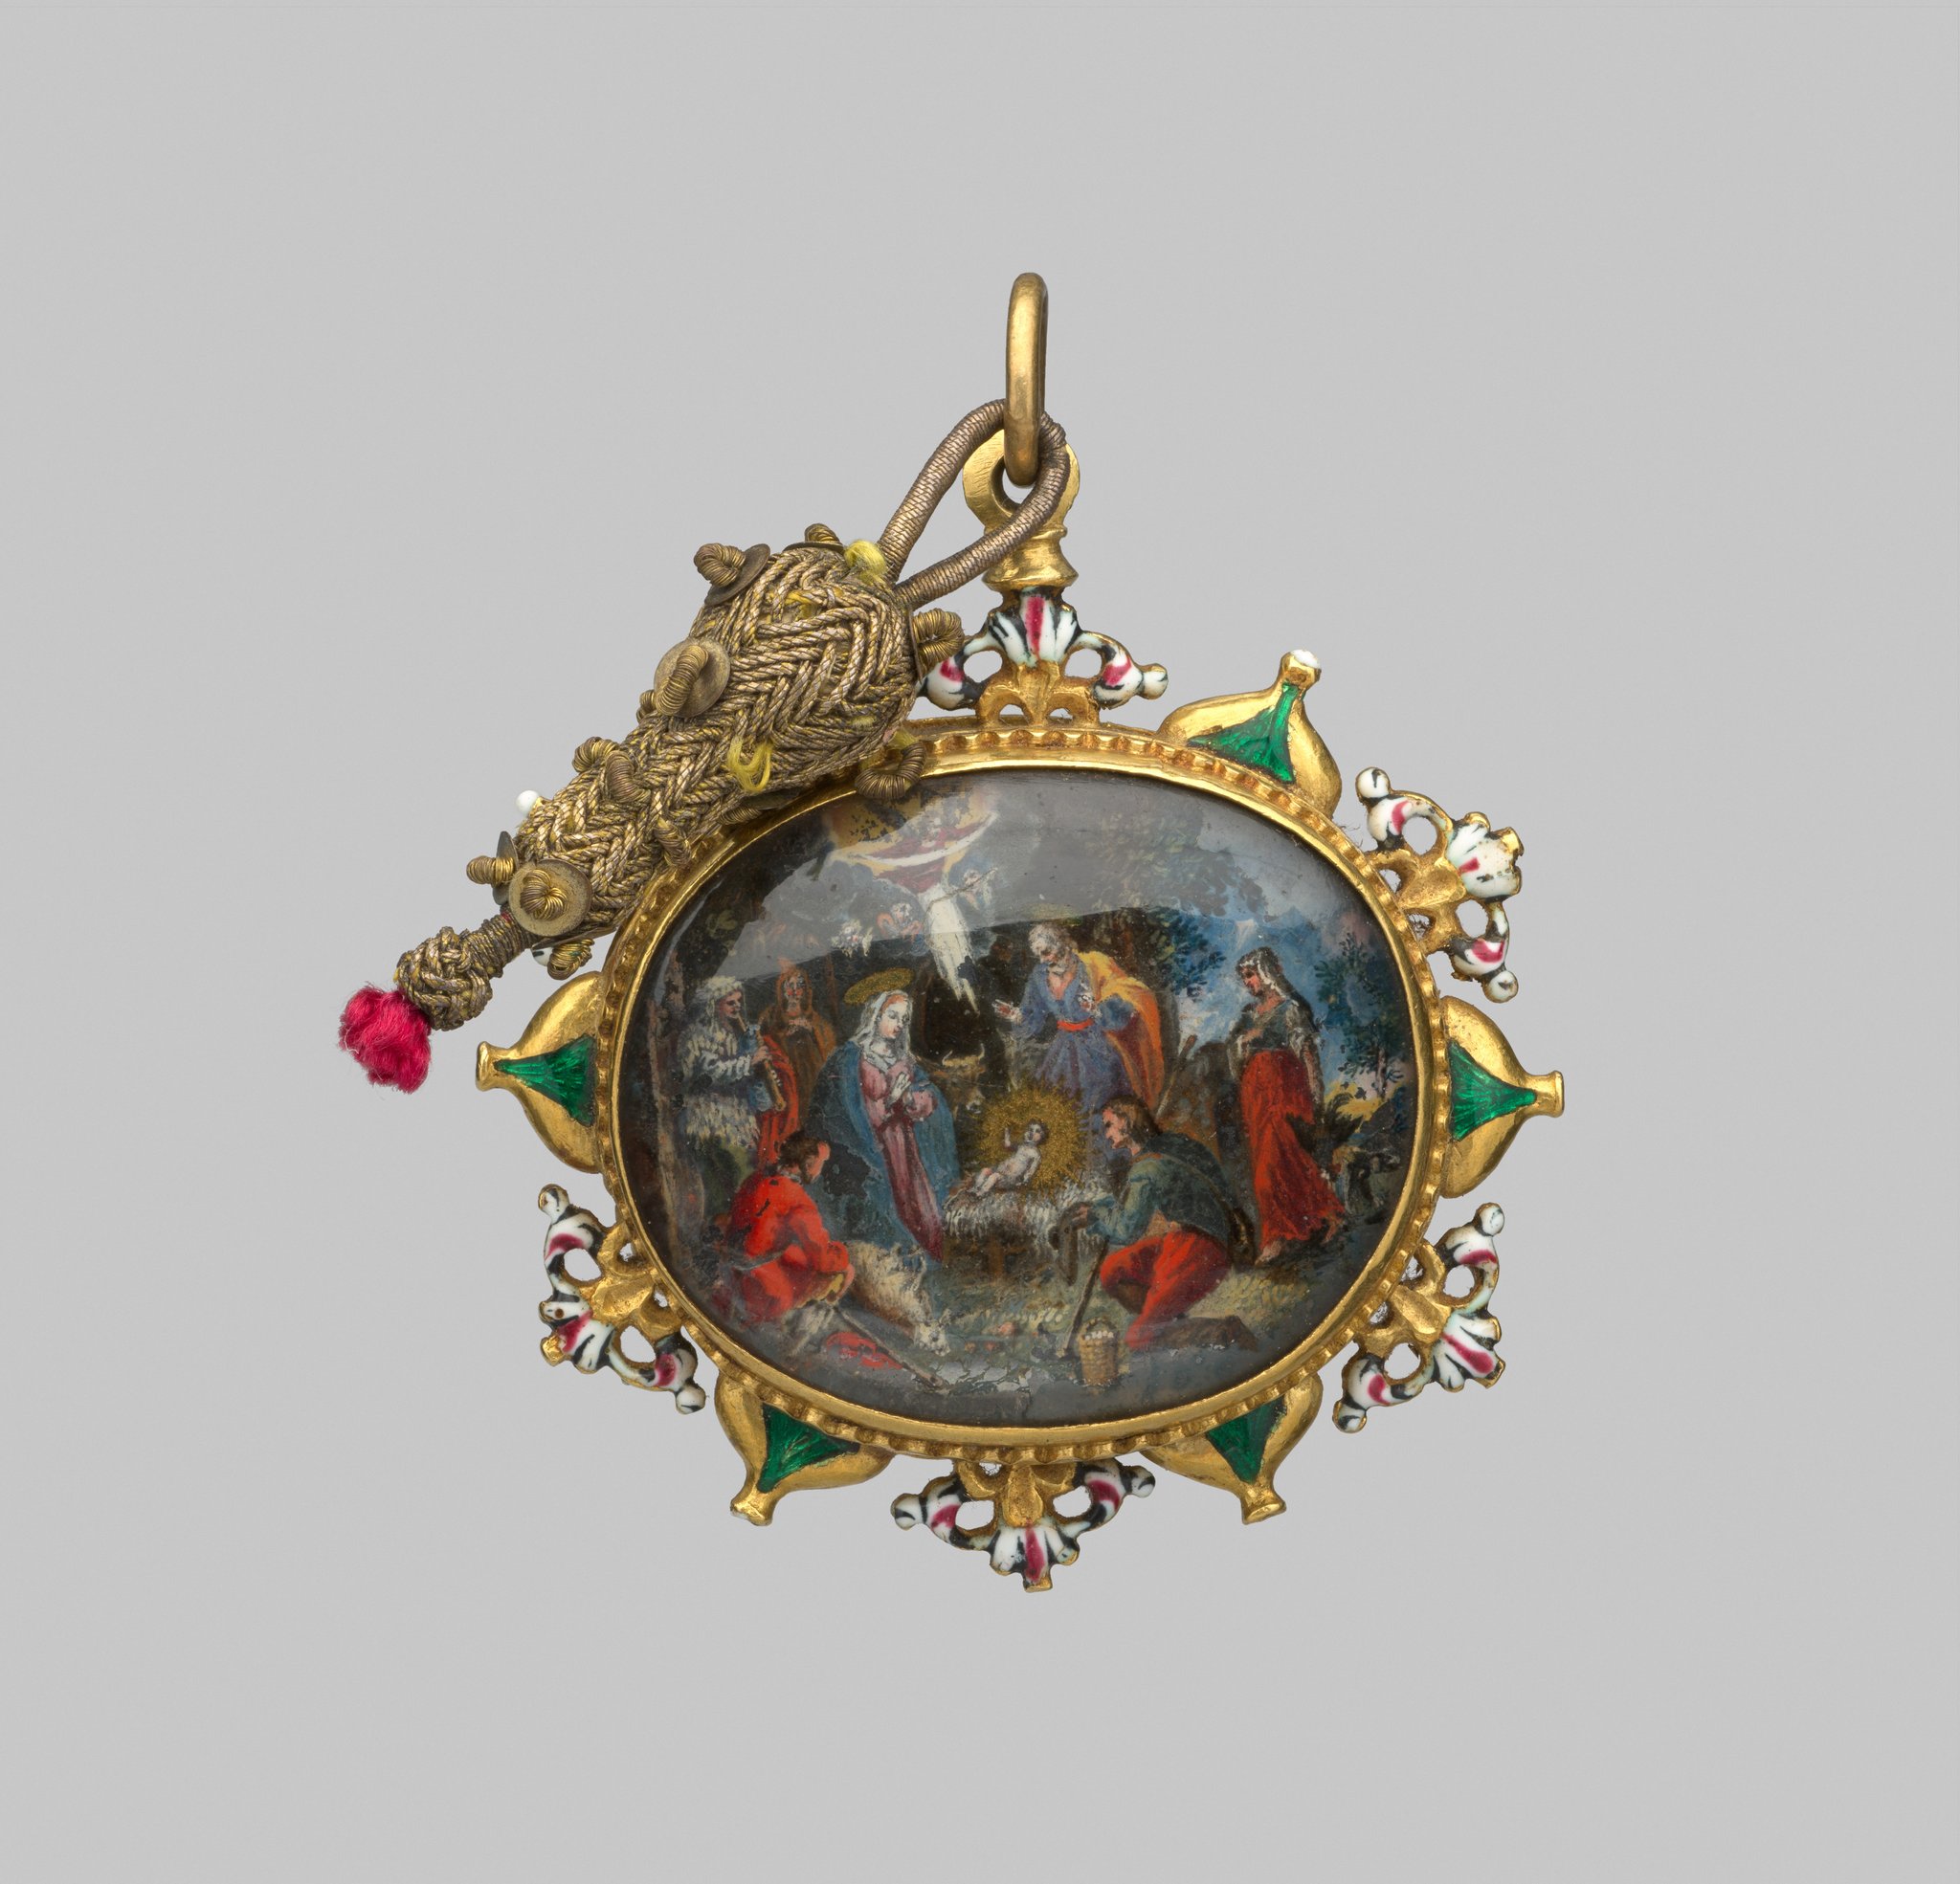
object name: pendant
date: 1601-1700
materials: enamel, gold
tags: nativity